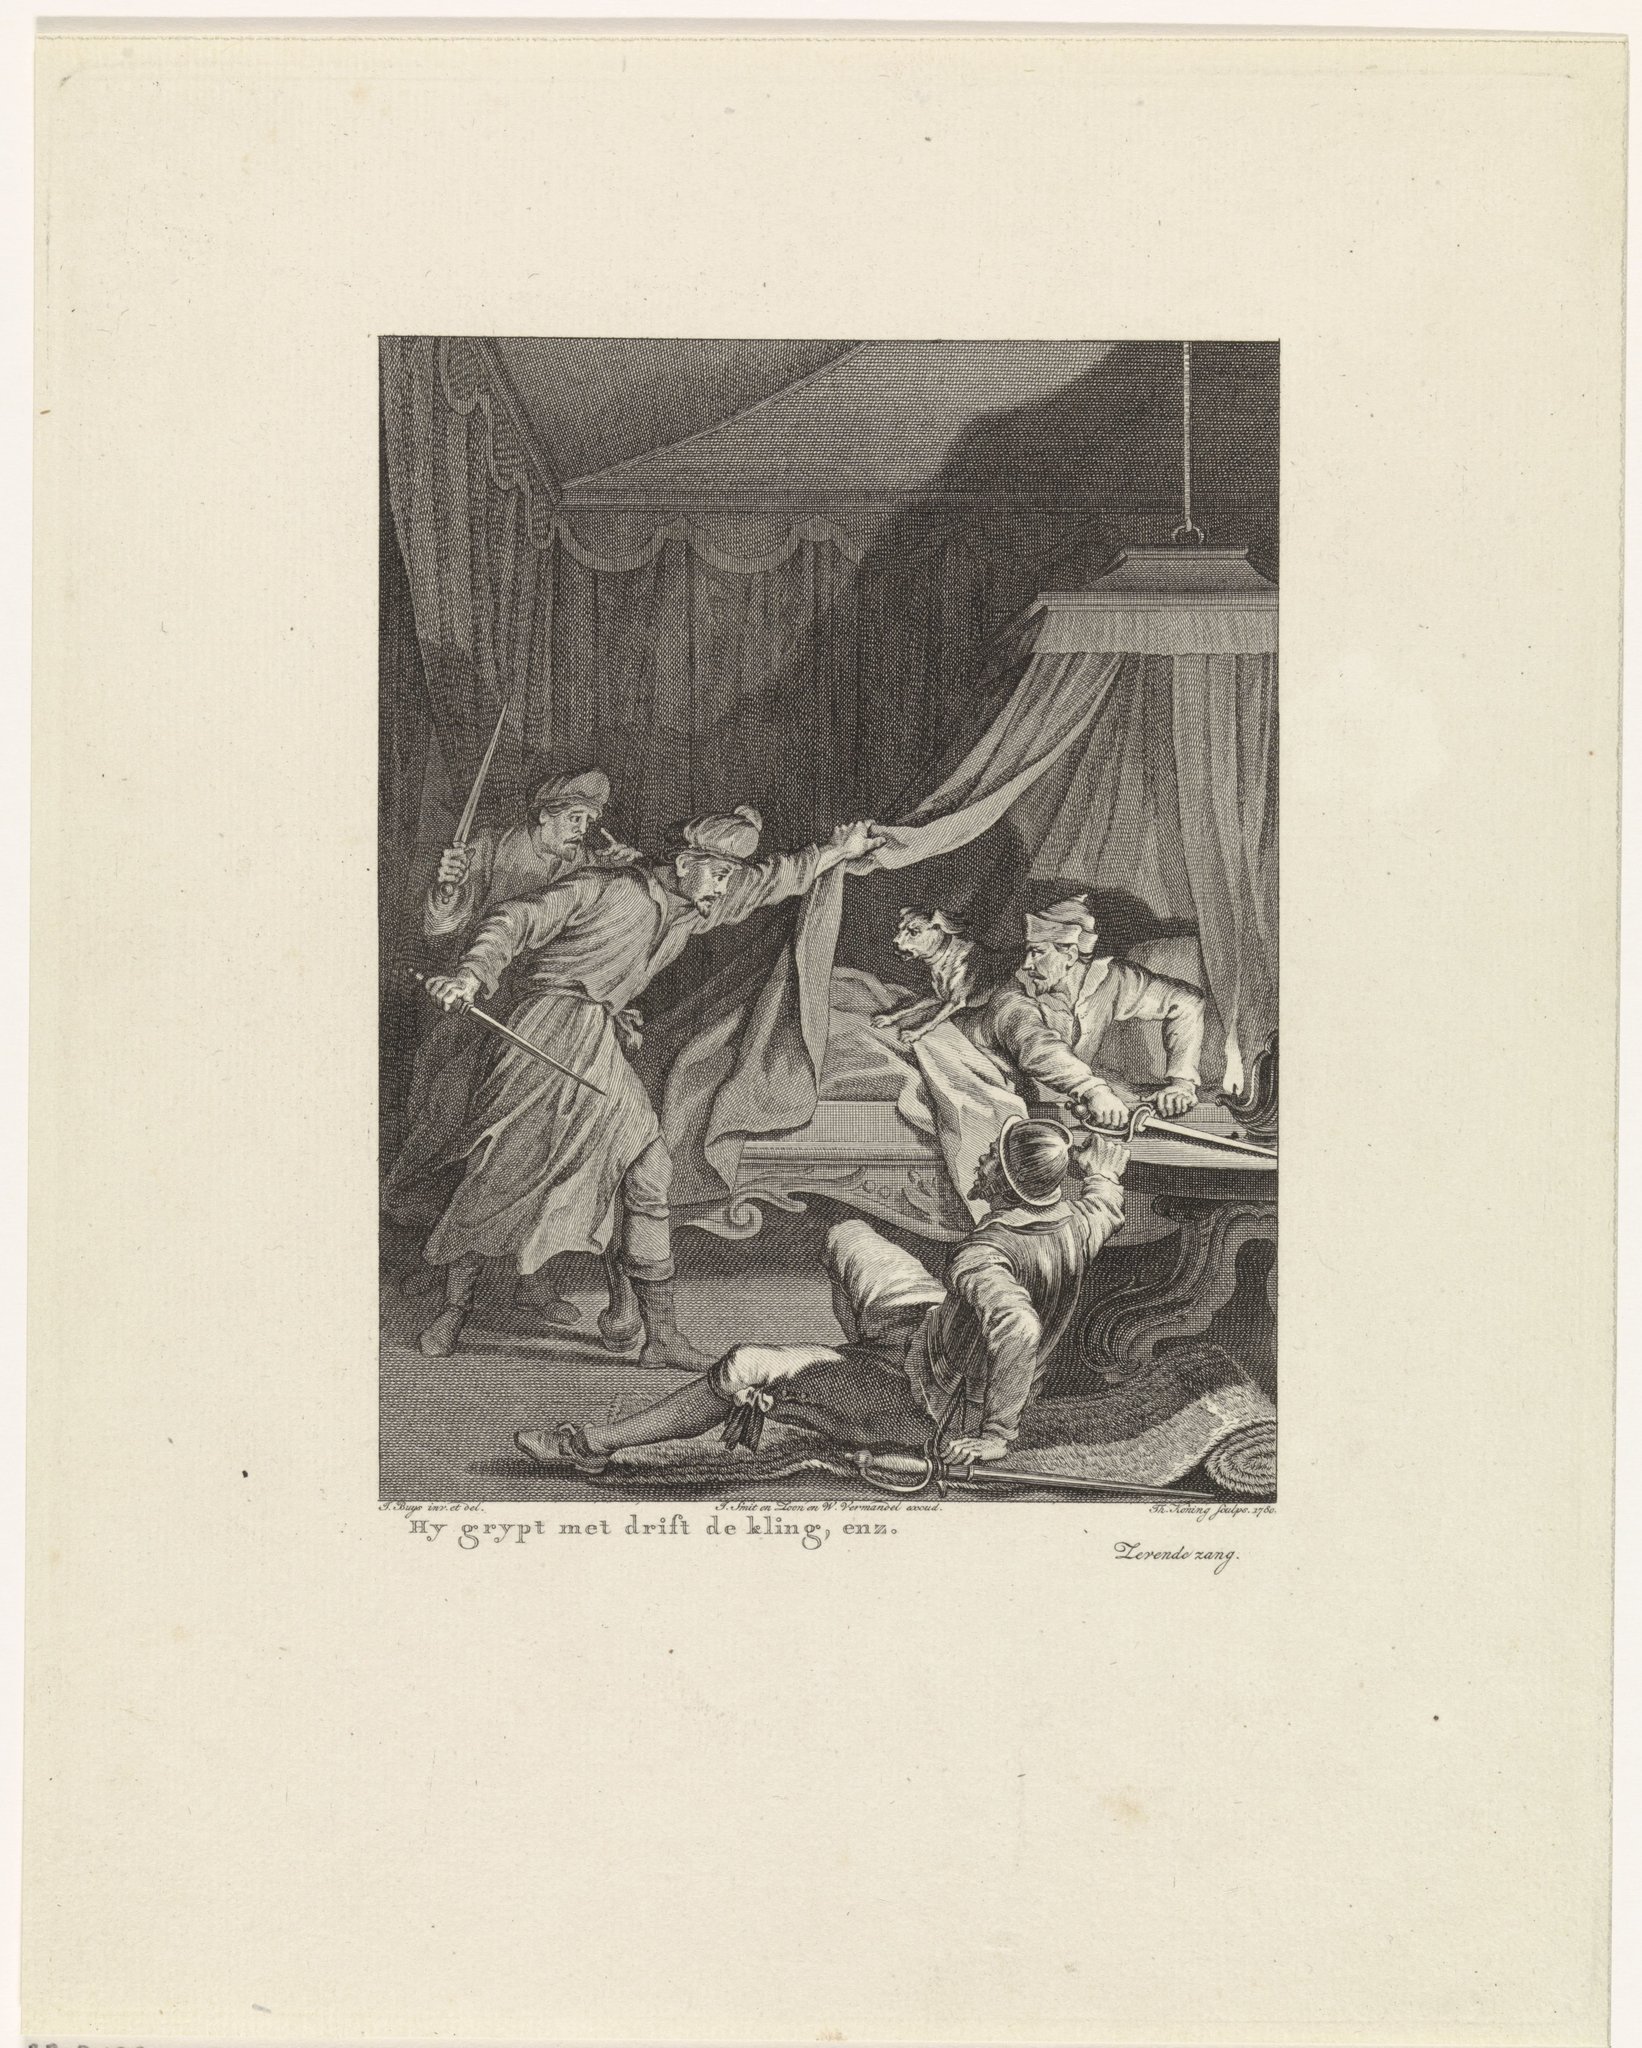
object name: history print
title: Taferelen uit het leven van prins Willem I, 1568-1584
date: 1779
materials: paper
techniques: engraving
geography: amsterdam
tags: william i (prince of orange), attempt, political murder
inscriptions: collector's mark: Lugt 2228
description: In de nacht van 11 op 12 september 1572 vindt er een aanslag op de prins van Oranje plaats. Net op tijd wordt Willem van Oranje, die in zijn legertent bij Bergen (Henegouwen) ligt te slapen, gewekt door het geblaf van zijn hond waardoor de aanslag mislukt. Deze prent maakt deel uit van een serie van 24 prenten met taferelen uit het leven van prins Willem I, 1568-1584 en is een illustratie bij de zevende zang.